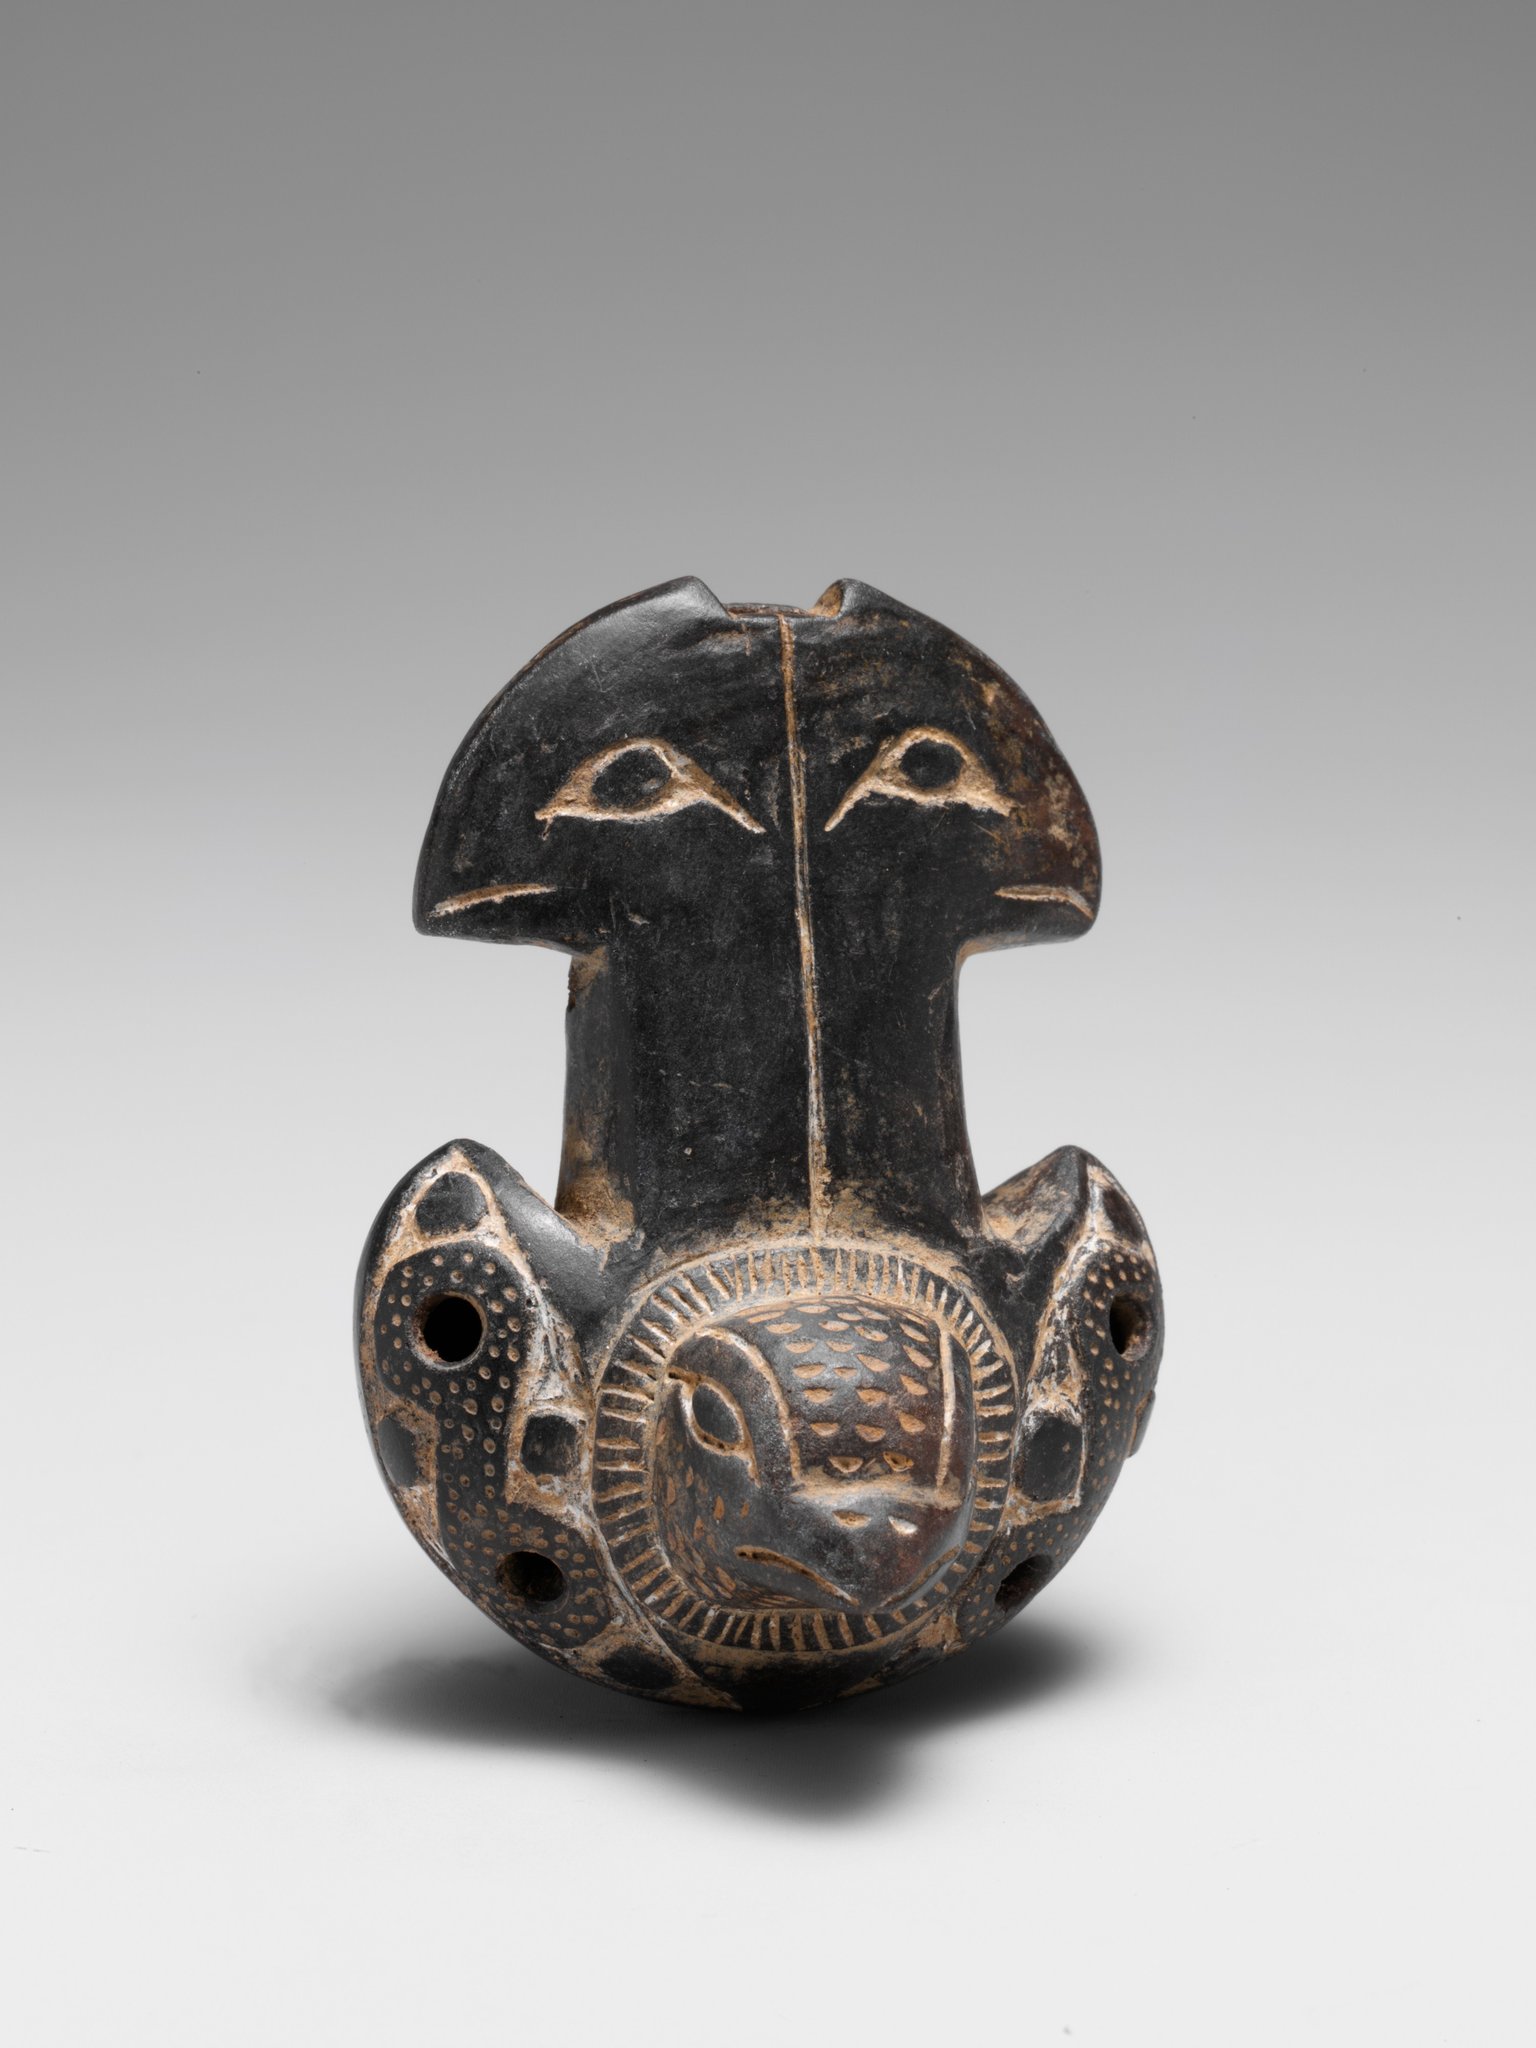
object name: ocarina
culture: tairona people or la aguja style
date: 1300-1500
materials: ceramic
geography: colombia